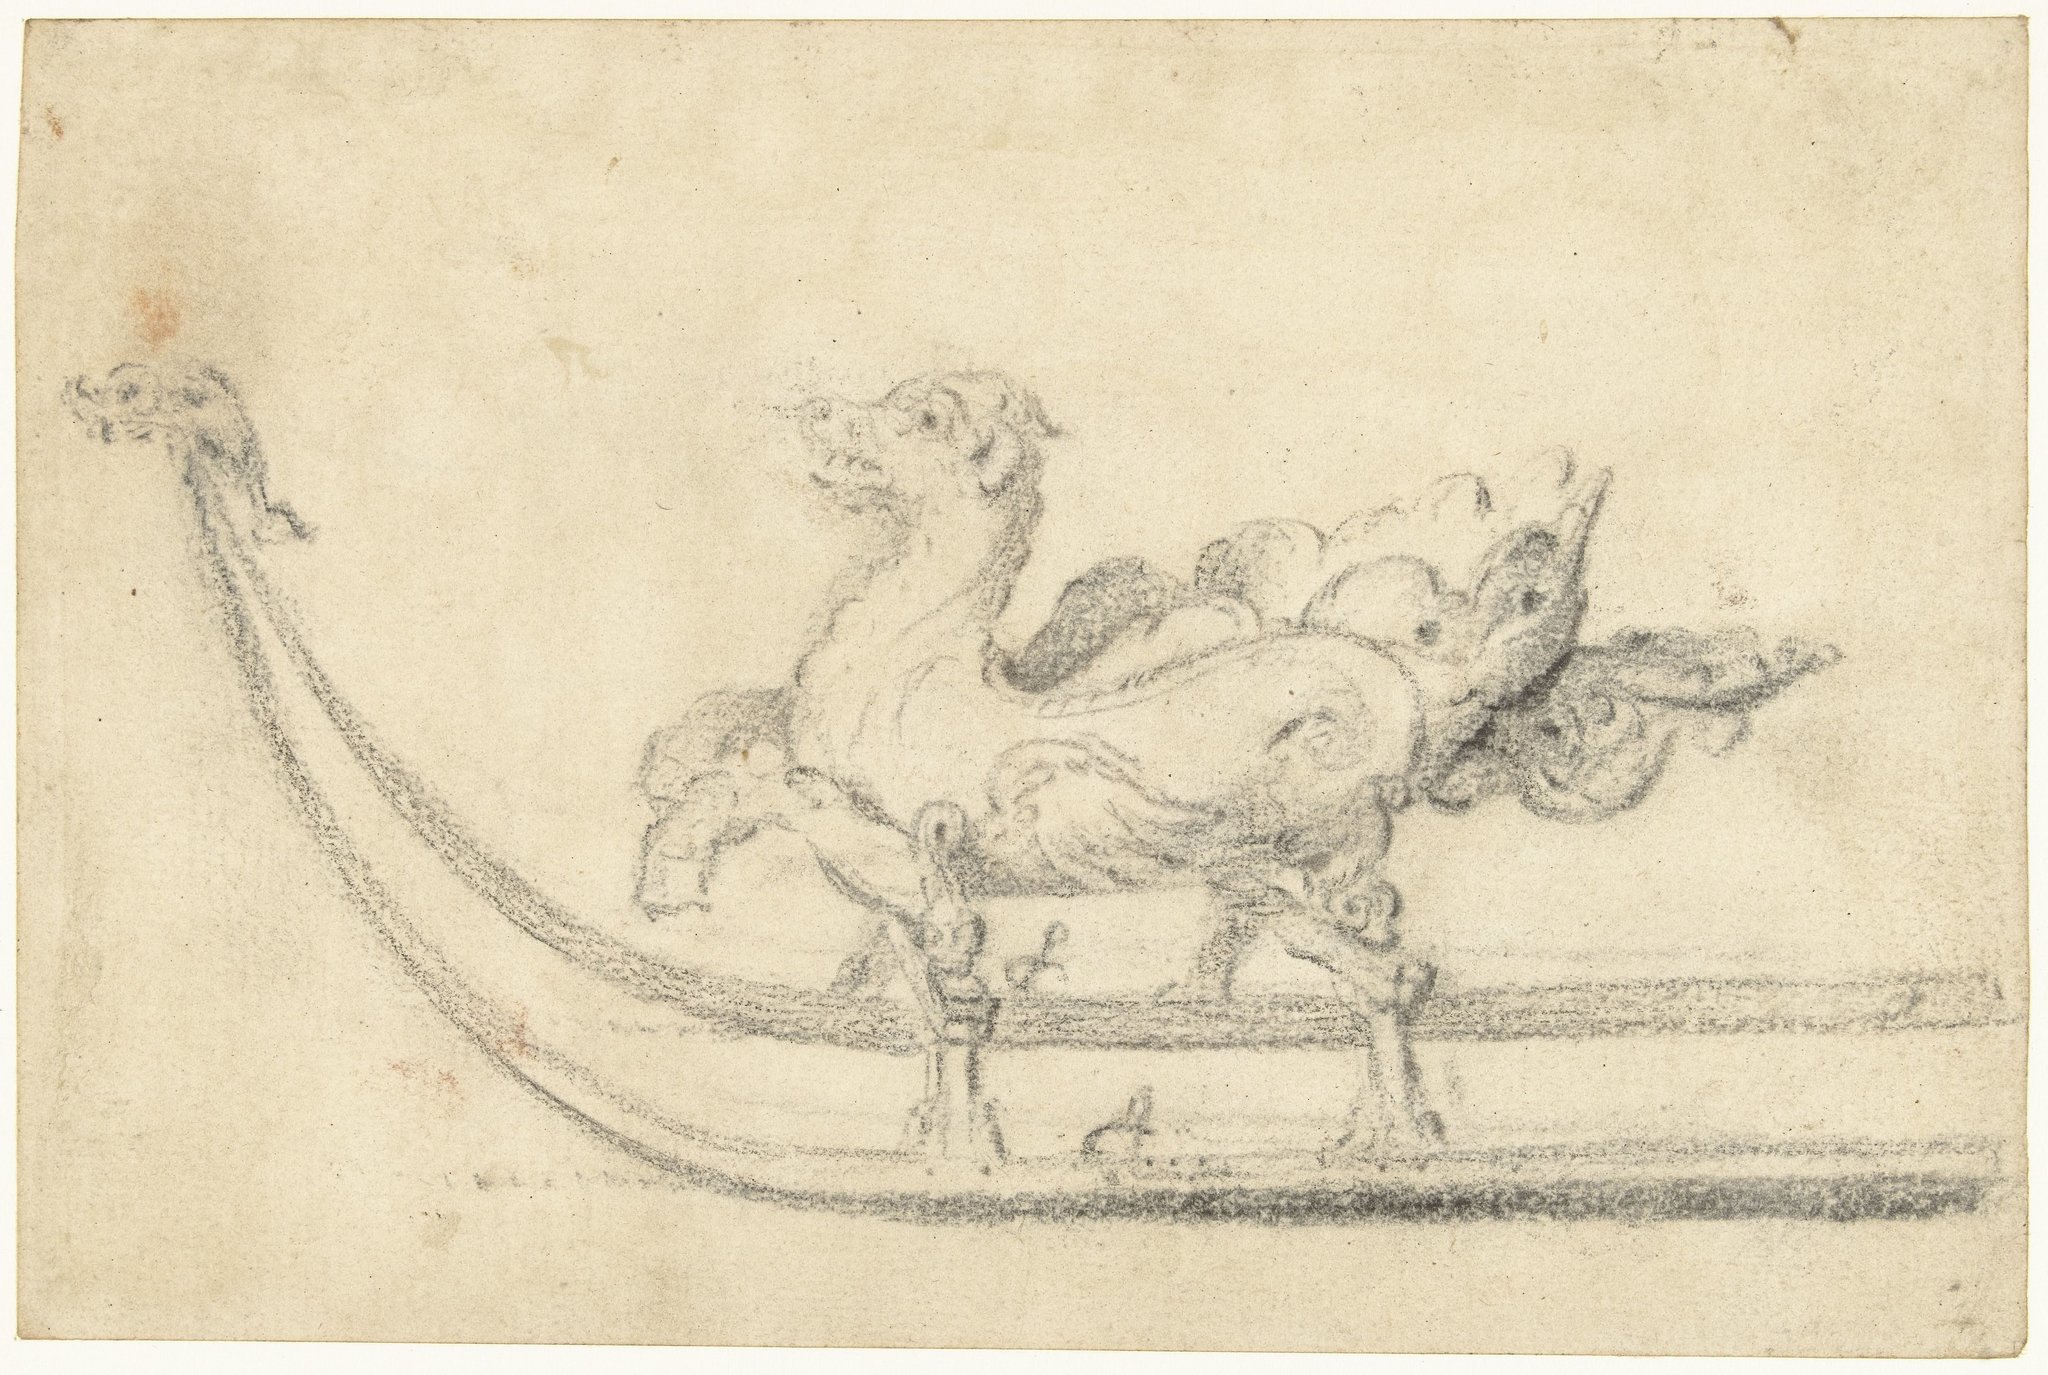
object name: drawing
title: Slede in de vorm van een gevleugelde draak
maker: gerard ter borch (ii)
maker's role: draughtsman, painter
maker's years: 1617-1681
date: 1654-1656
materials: chalk, paper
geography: deventer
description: Een slede in de vorm van een gevleugelde draak. Drakensleden komen weinig voor in schilderijen van ijsvermaak, maar hebben wel bestaan.